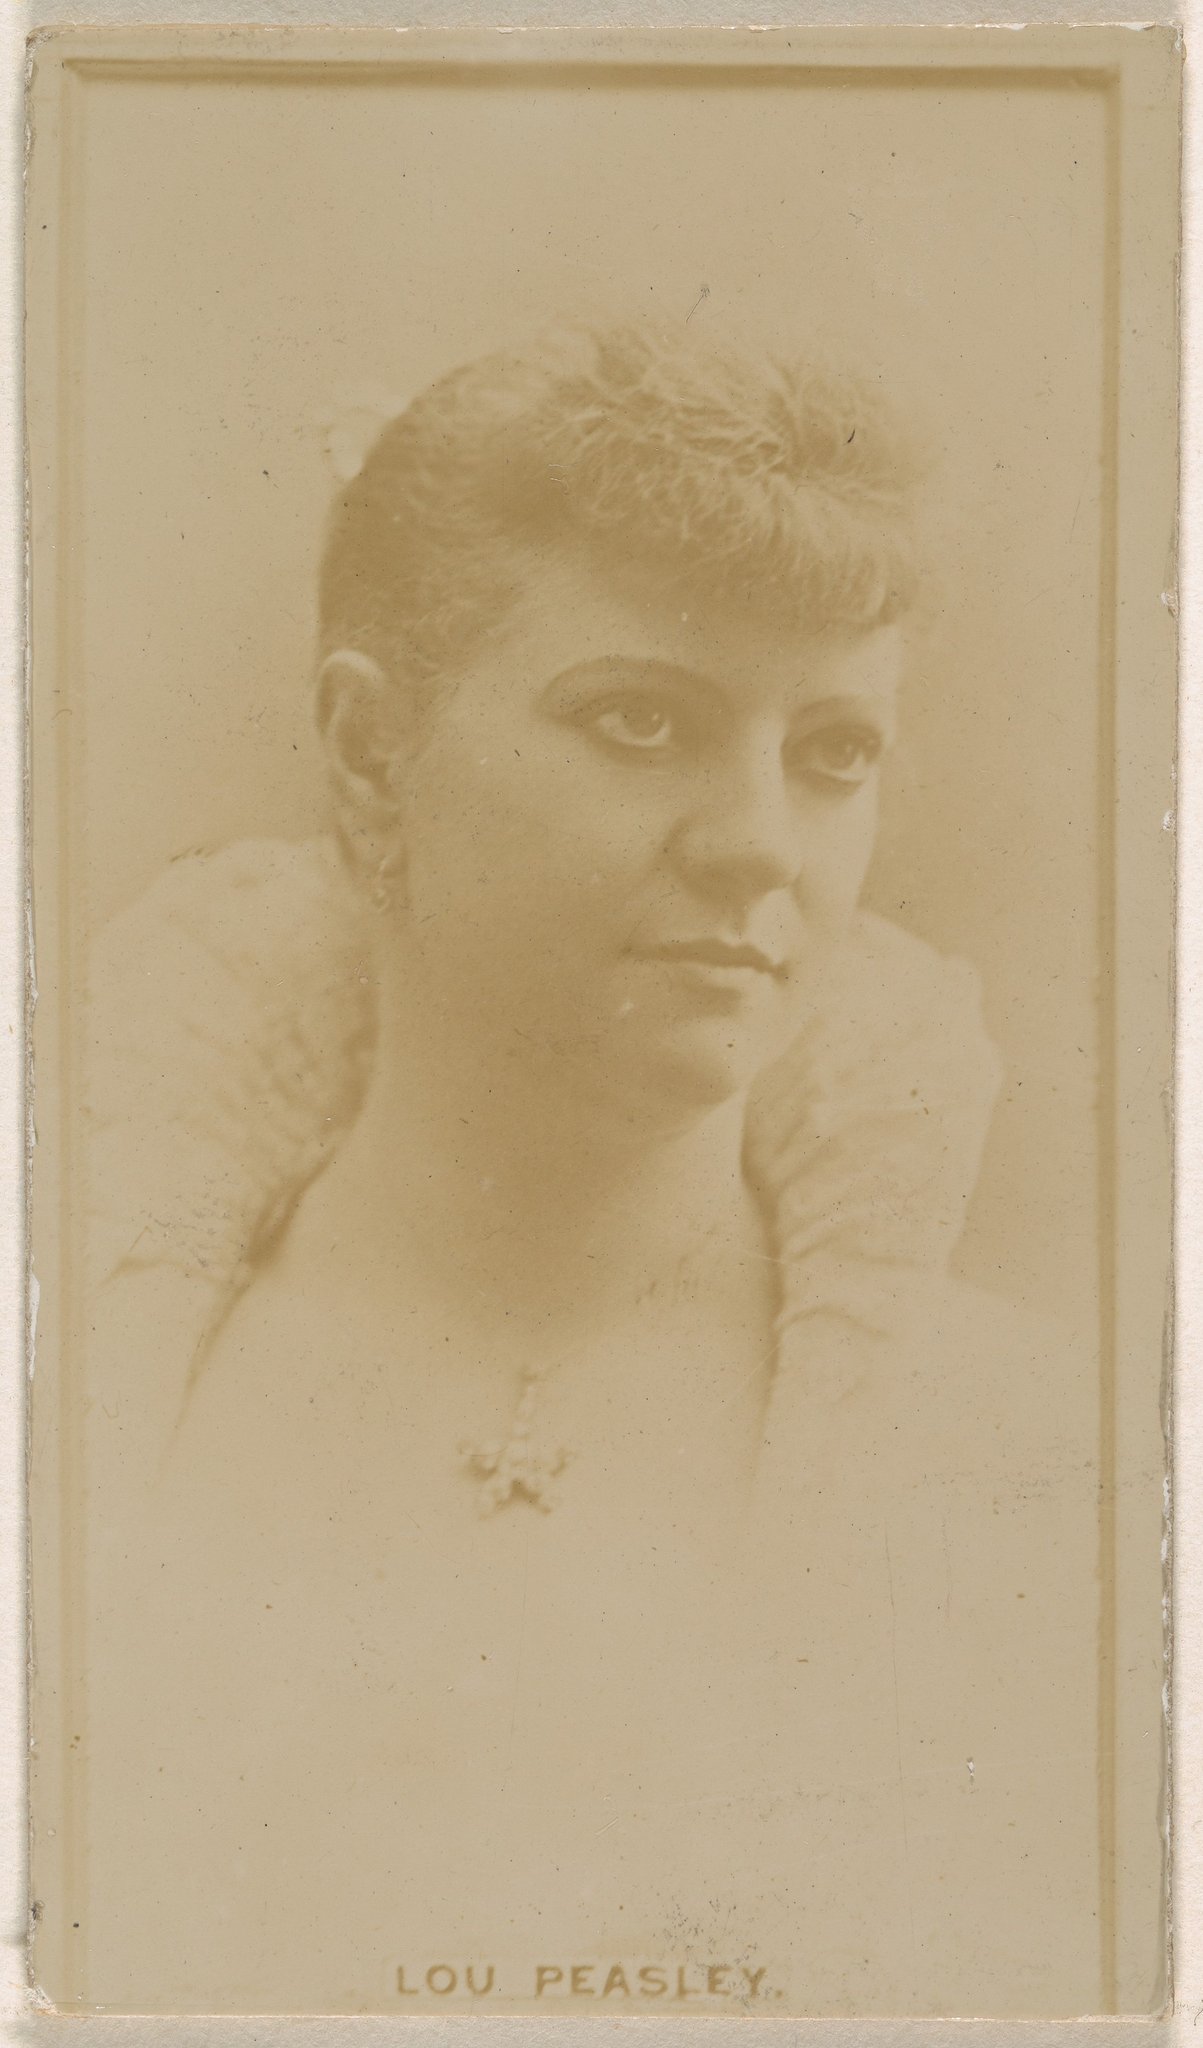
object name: photograph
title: Lou Peasley, from the Actresses series (N245) issued by Kinney Brothers to promote Sweet Caporal Cigarettes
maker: kinney brothers tobacco company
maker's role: publisher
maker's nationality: american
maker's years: 1869-2011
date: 1890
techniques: albumen silver print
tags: portraits,women,actresses